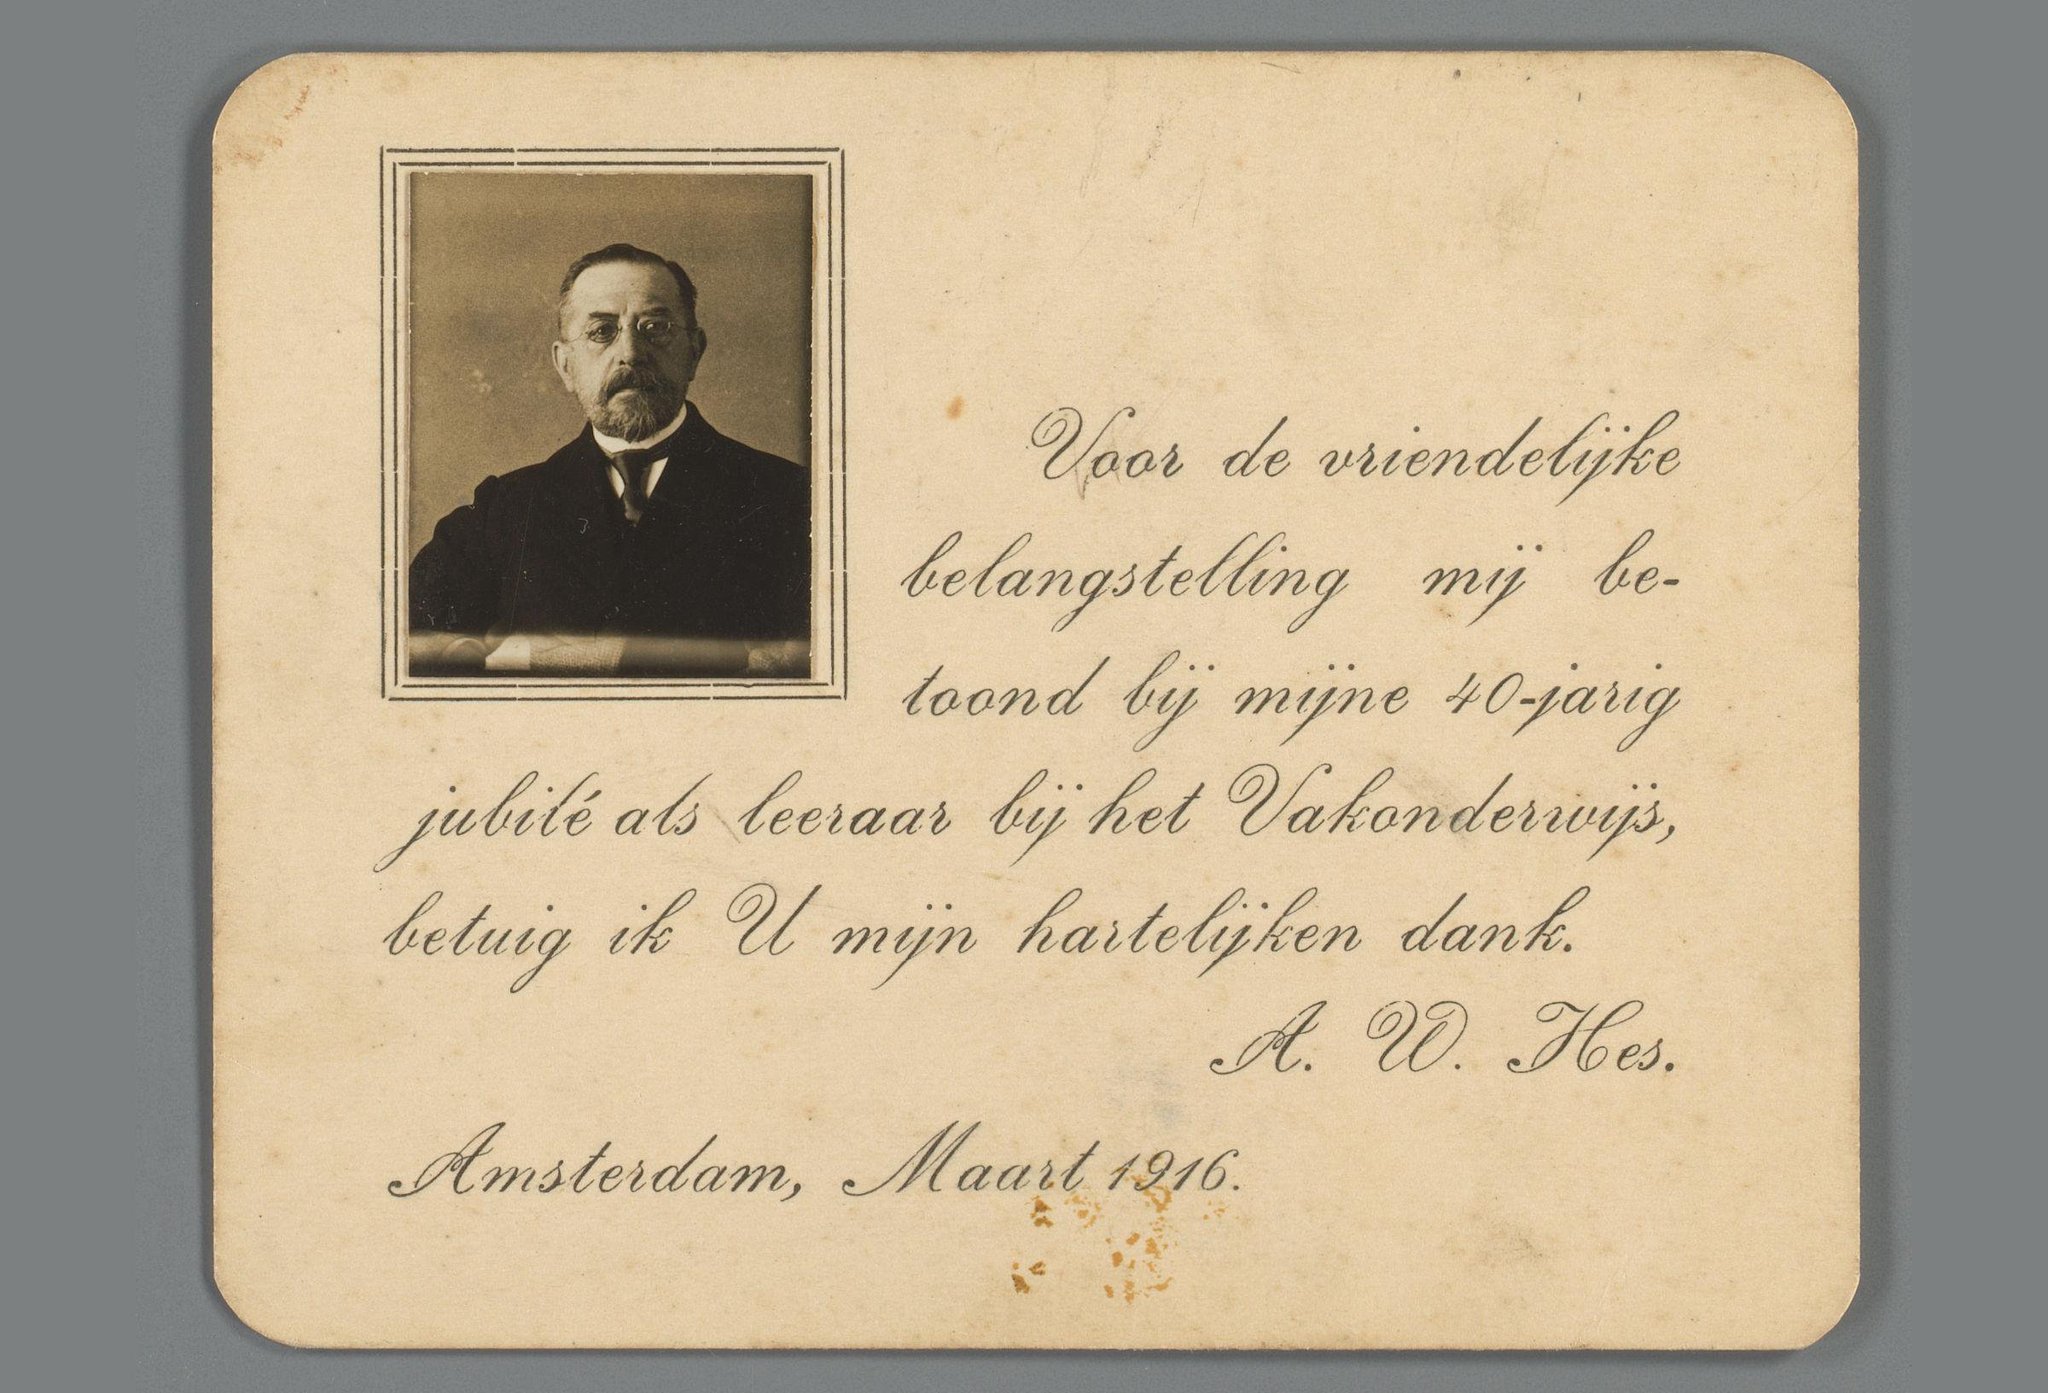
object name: photograph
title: Portret van A.W. Hes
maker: Anonymous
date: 1916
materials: paper, cardboard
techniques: gelatin silver print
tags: historical persons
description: Bedankkaart van de heer A.W. Hes voor de getoonde belangstelling bij zijn 40-jarig ambtsjubileum met foto van de jubilaris.